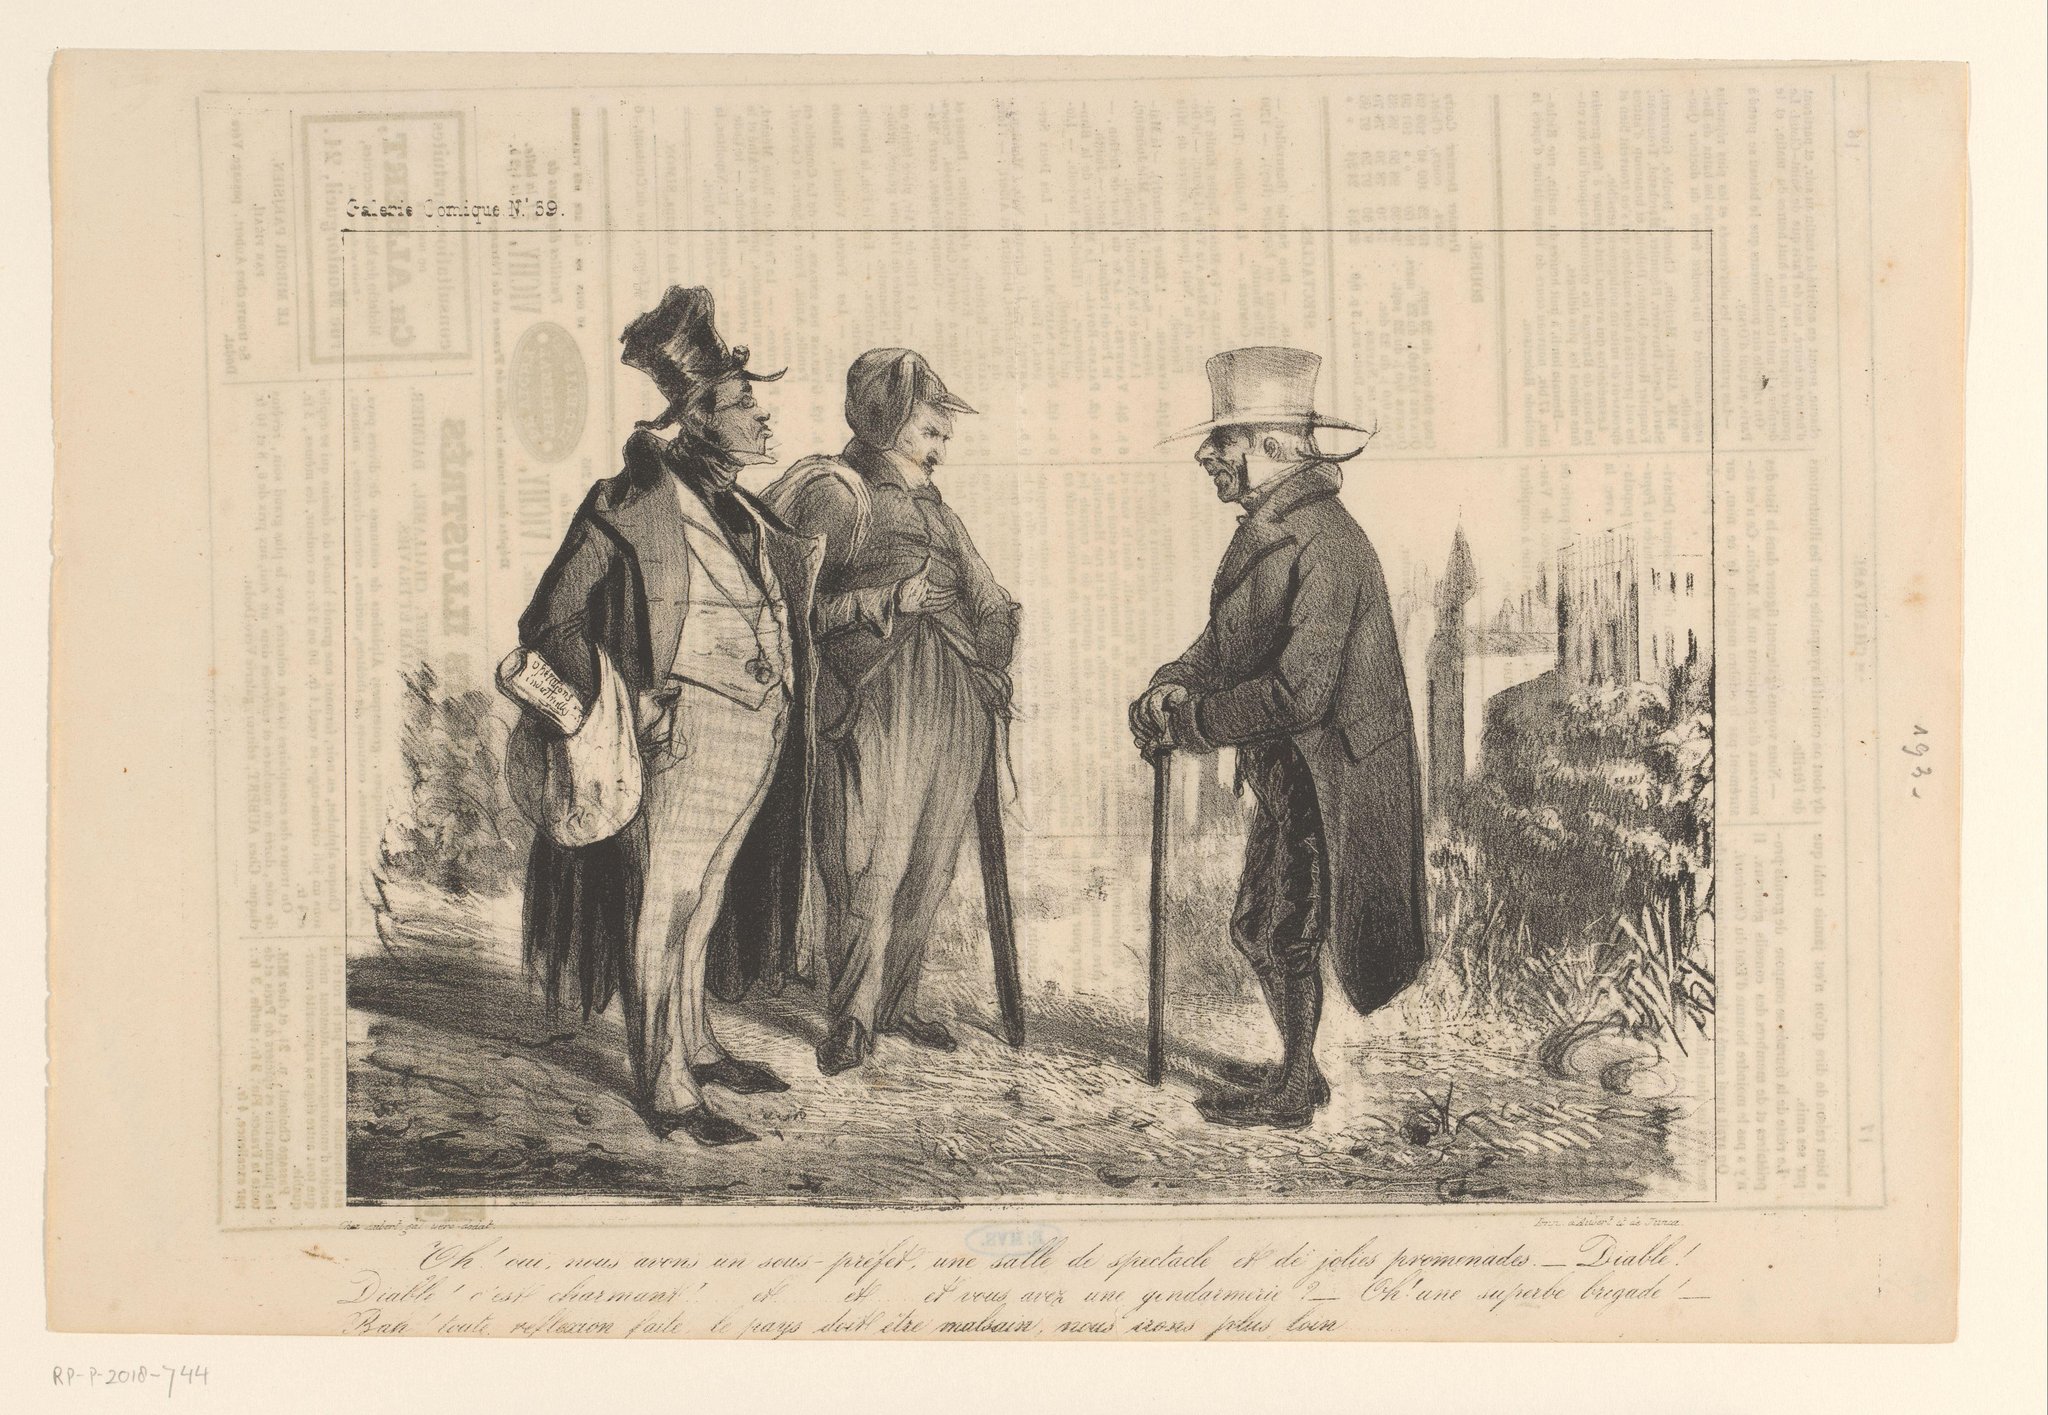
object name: cartoon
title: Drie mannen in gesprek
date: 1830-1880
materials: paper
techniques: lithograph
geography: paris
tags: political caricatures and satires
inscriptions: collector's mark: Lugt 2228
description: Spotprent met drie mannen in gesprek op een pad buiten de stad. Met drieregelig Frans onderchrift. Linksboven: Galerie Comique No. 59. Op een blad bedrukt op verso met tekst.